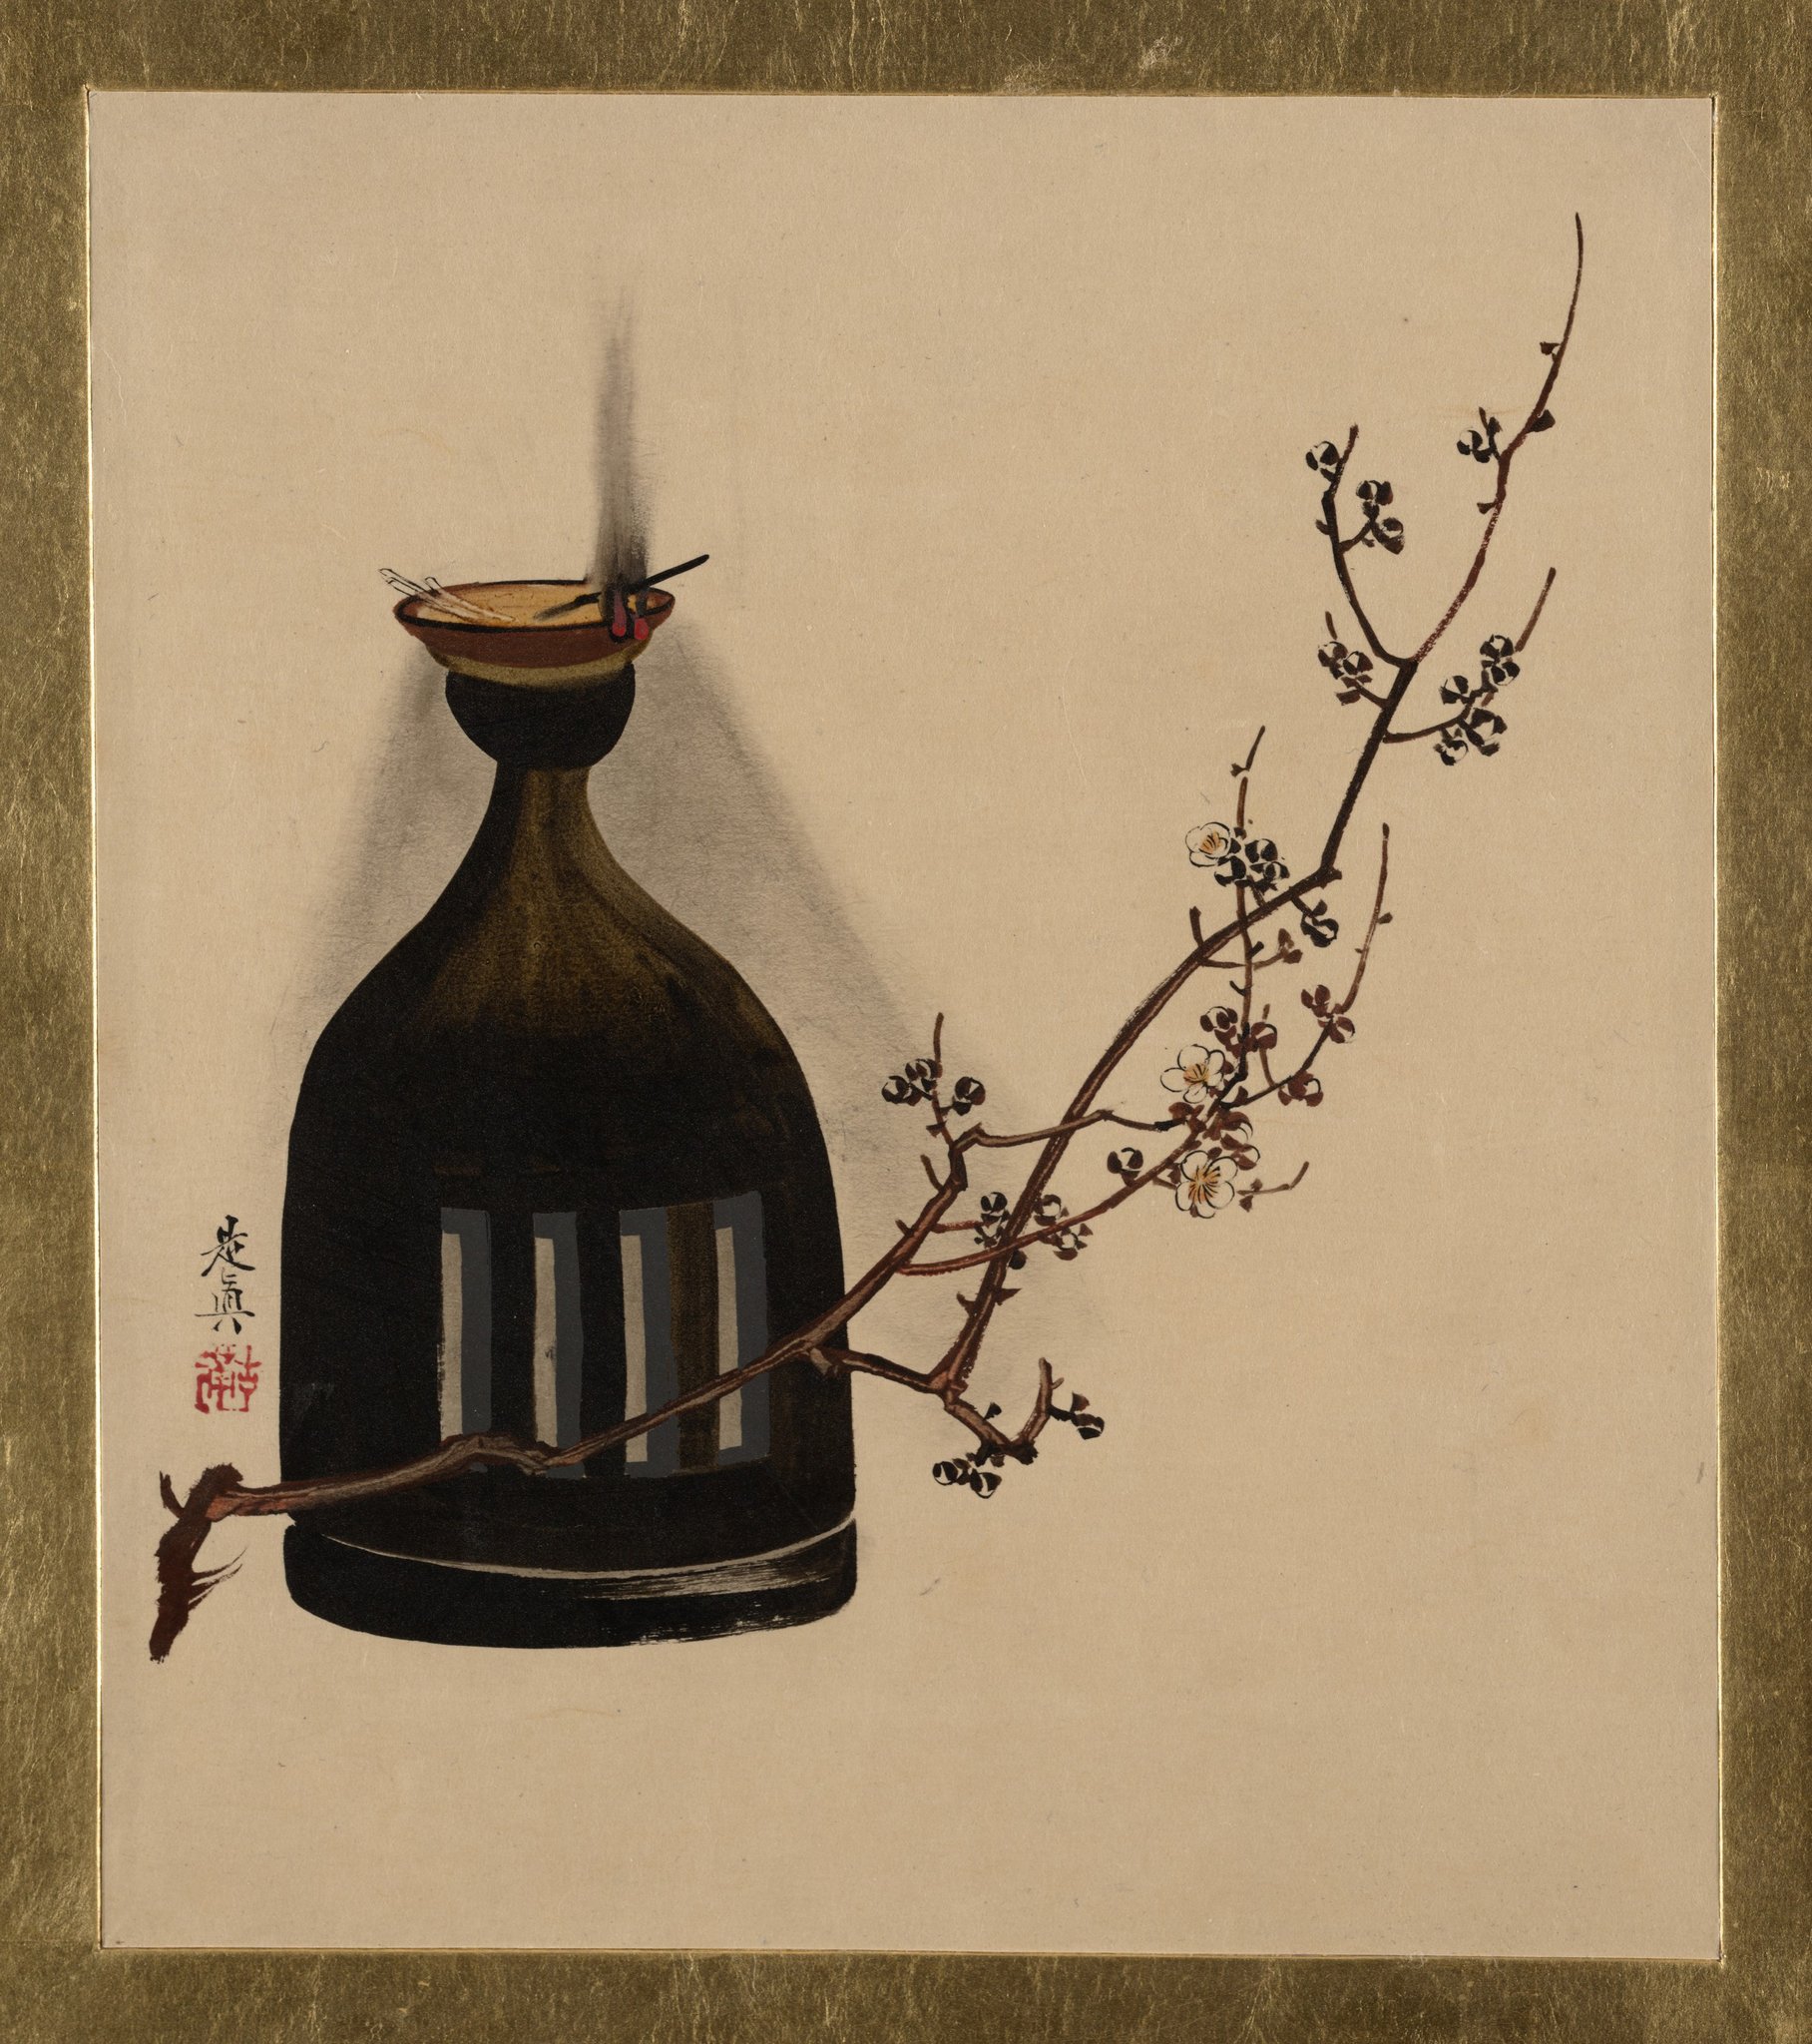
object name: album leaf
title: Lacquer Paintings of Various Subjects: Plum Branch with Oil Lamp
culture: japanese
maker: shibata zeshin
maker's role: artist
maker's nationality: japanese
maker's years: 1807-1891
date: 1882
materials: lacquer, paper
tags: flowers,lamps